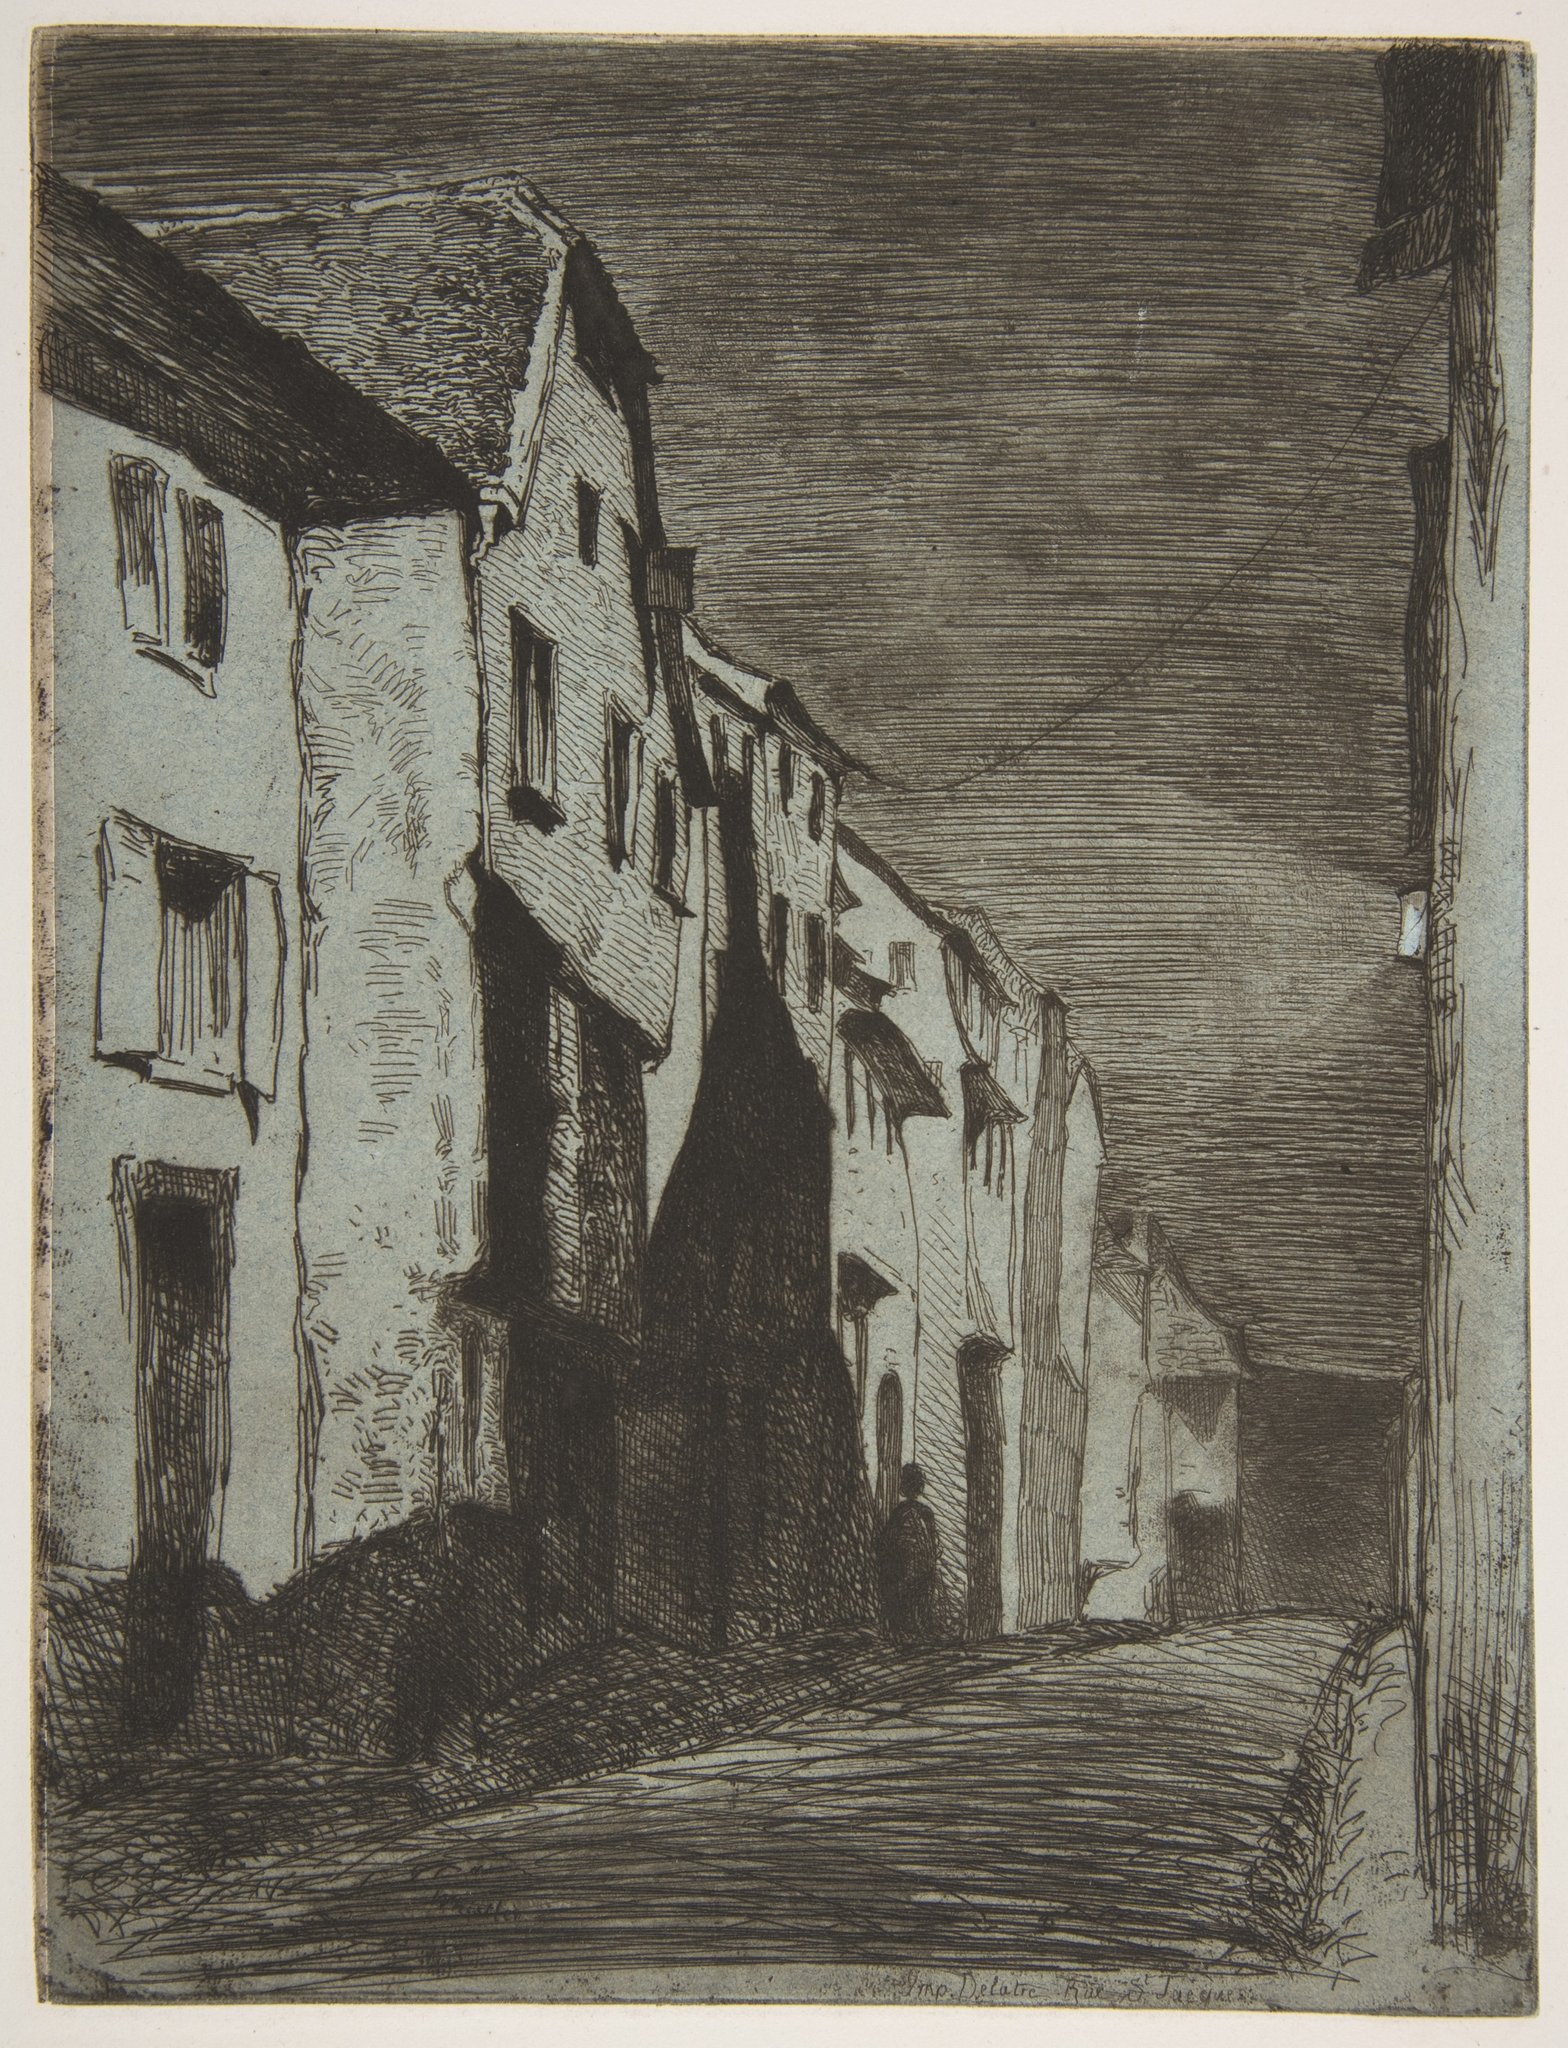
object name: print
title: Street at Saverne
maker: james mcneill whistler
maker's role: artist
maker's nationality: american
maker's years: 1834-1903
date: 1858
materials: chine, ink, paper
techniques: printmaking, etching, printing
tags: buildings